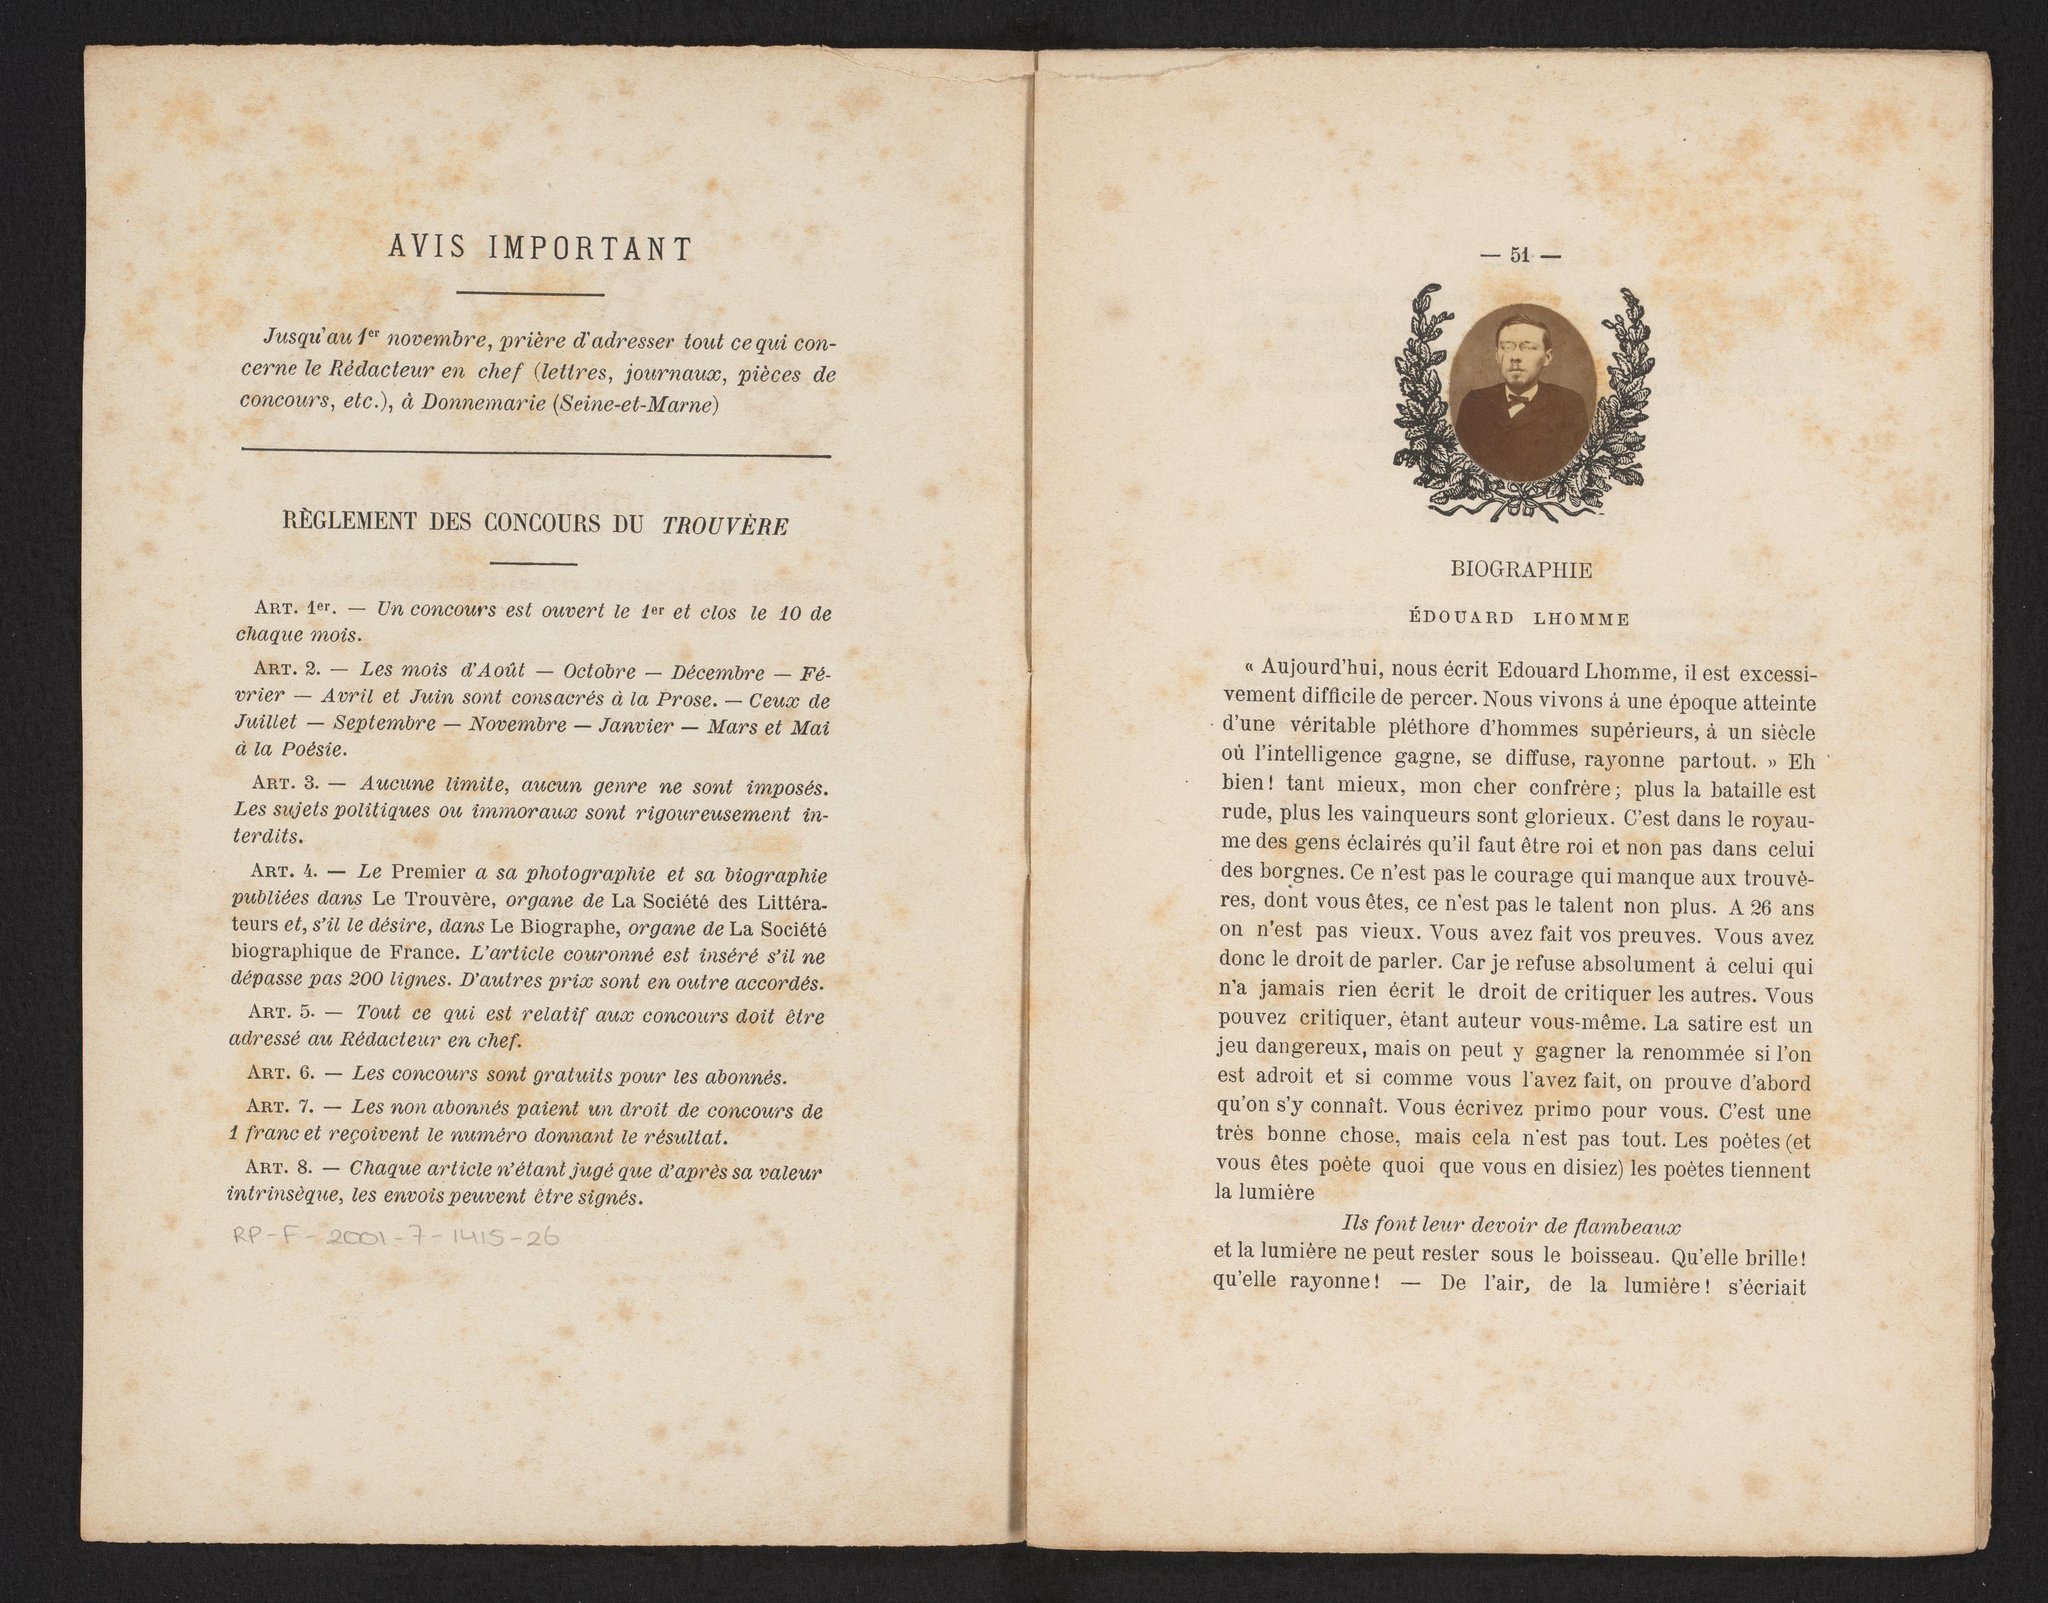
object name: page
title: Portret van Édouard Lhomme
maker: Anonymous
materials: photographic support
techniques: albumen print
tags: historical persons